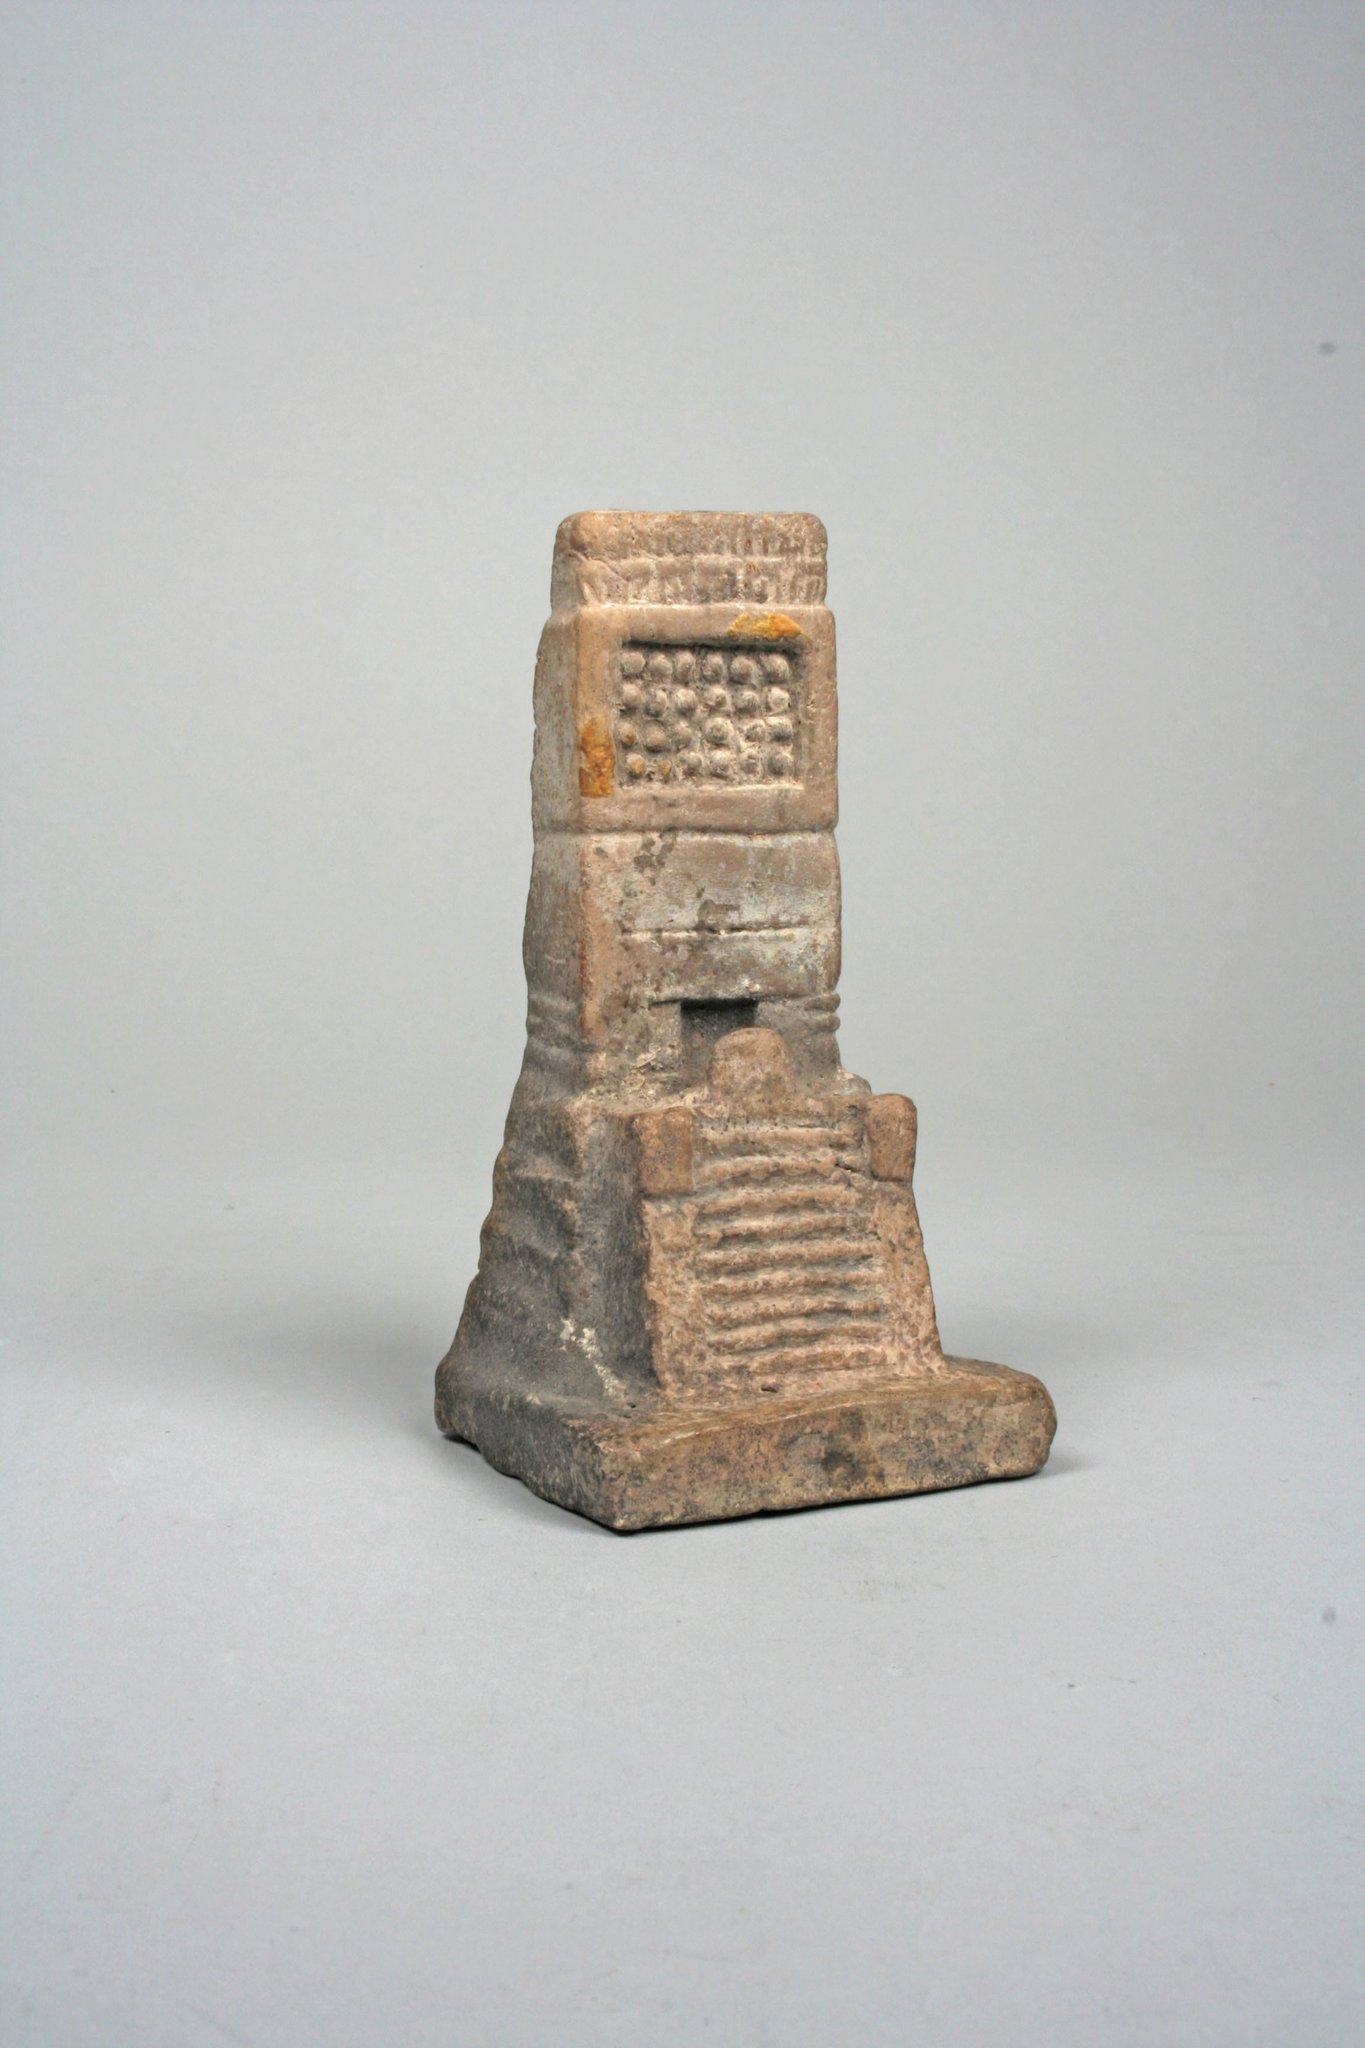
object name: temple model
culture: mexica, aztec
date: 1401-1533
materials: ceramic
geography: mexico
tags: temples